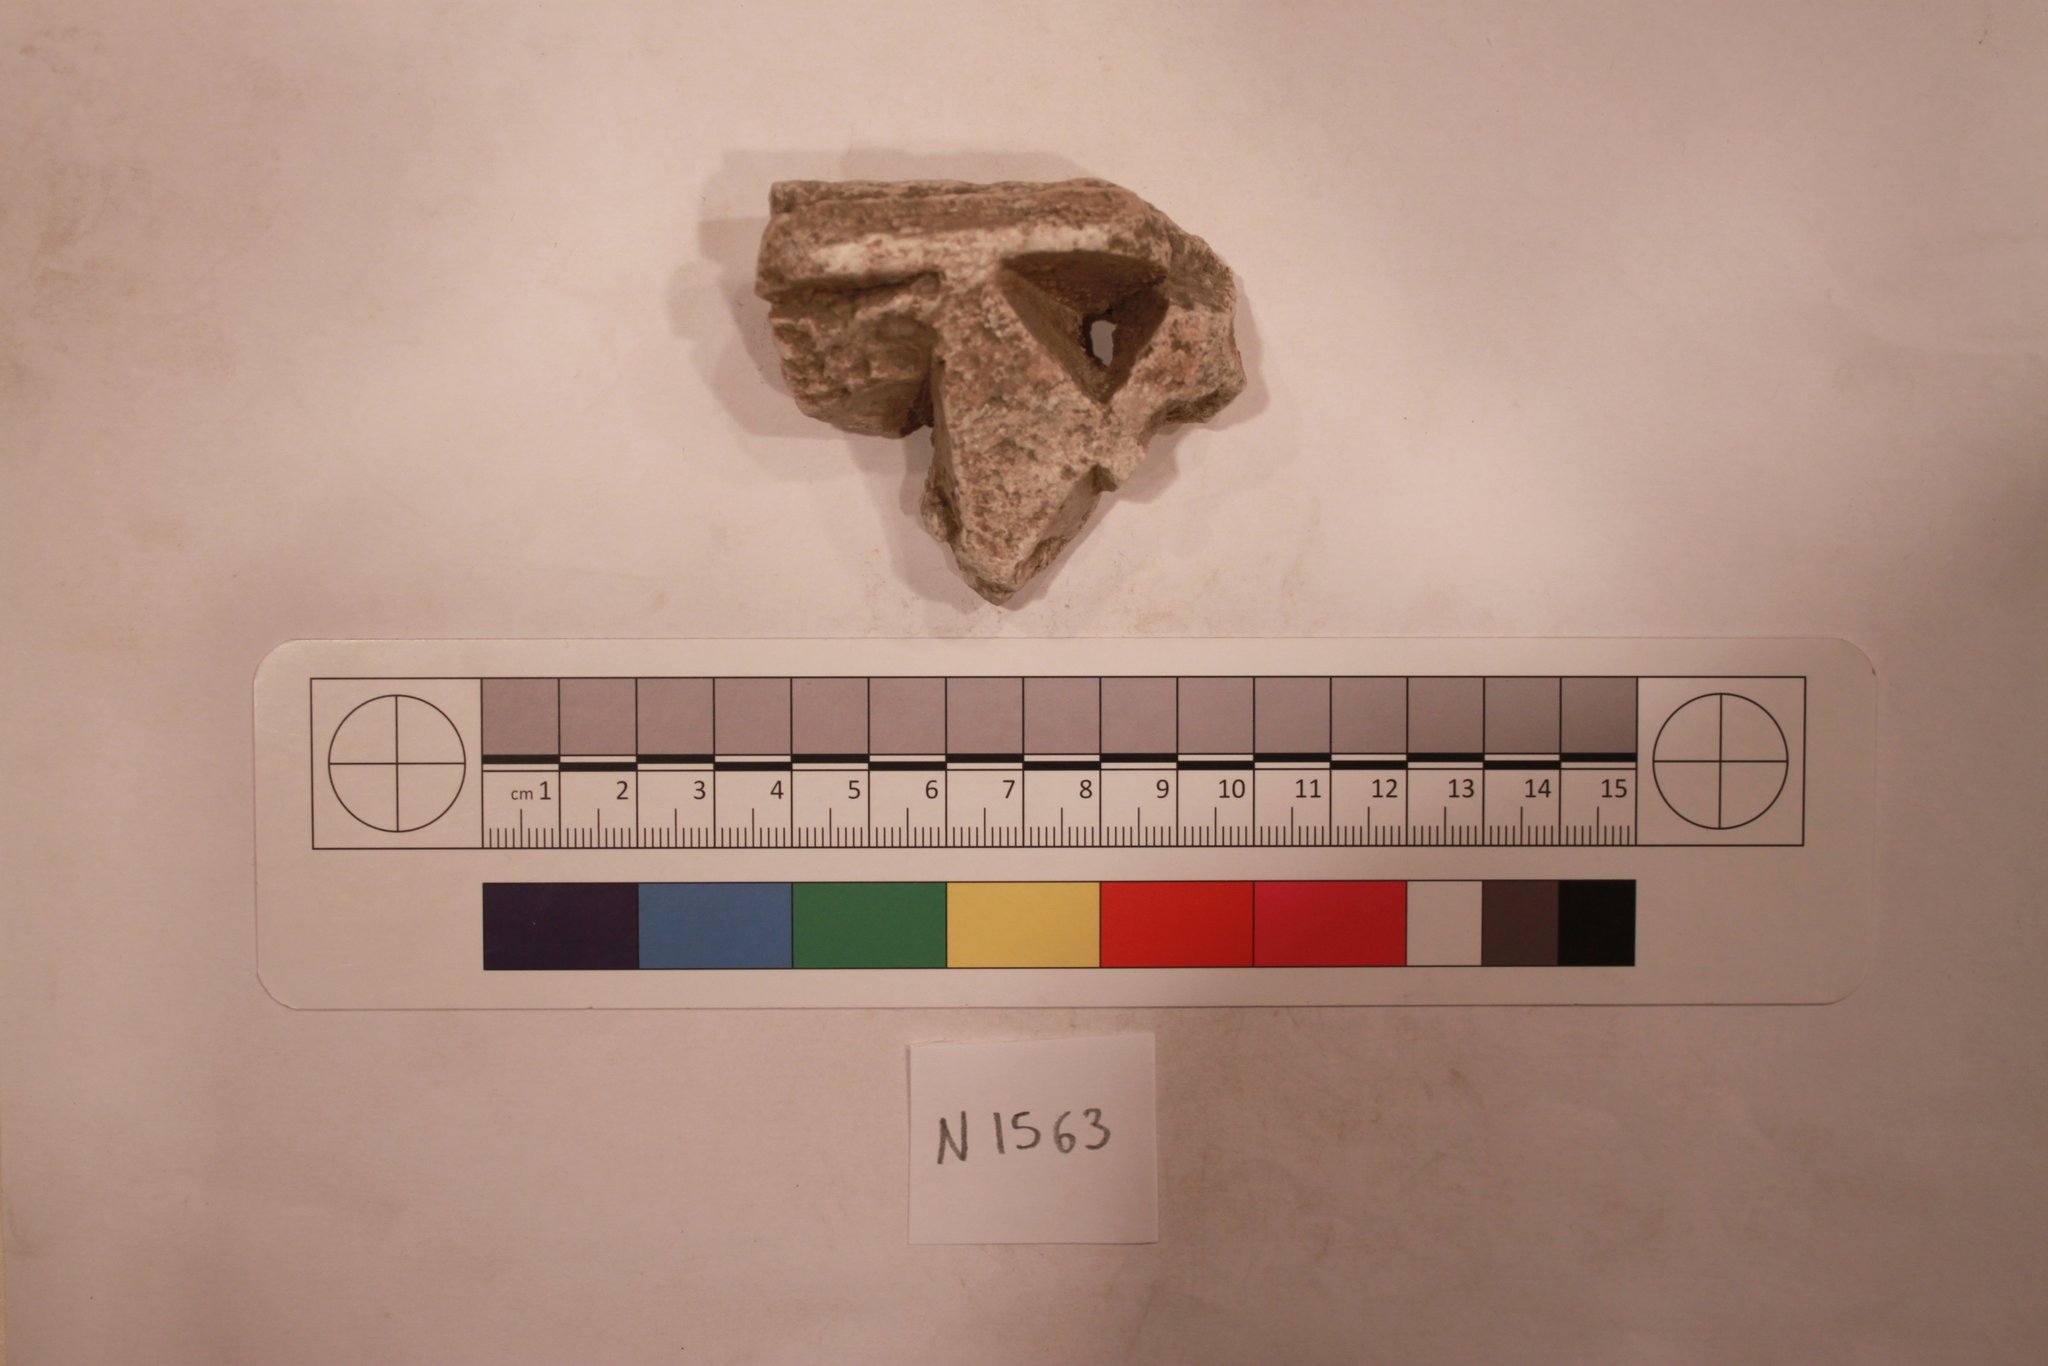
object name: fragment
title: Stucco Fragment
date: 701-1200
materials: plaster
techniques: carving, painting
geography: iran